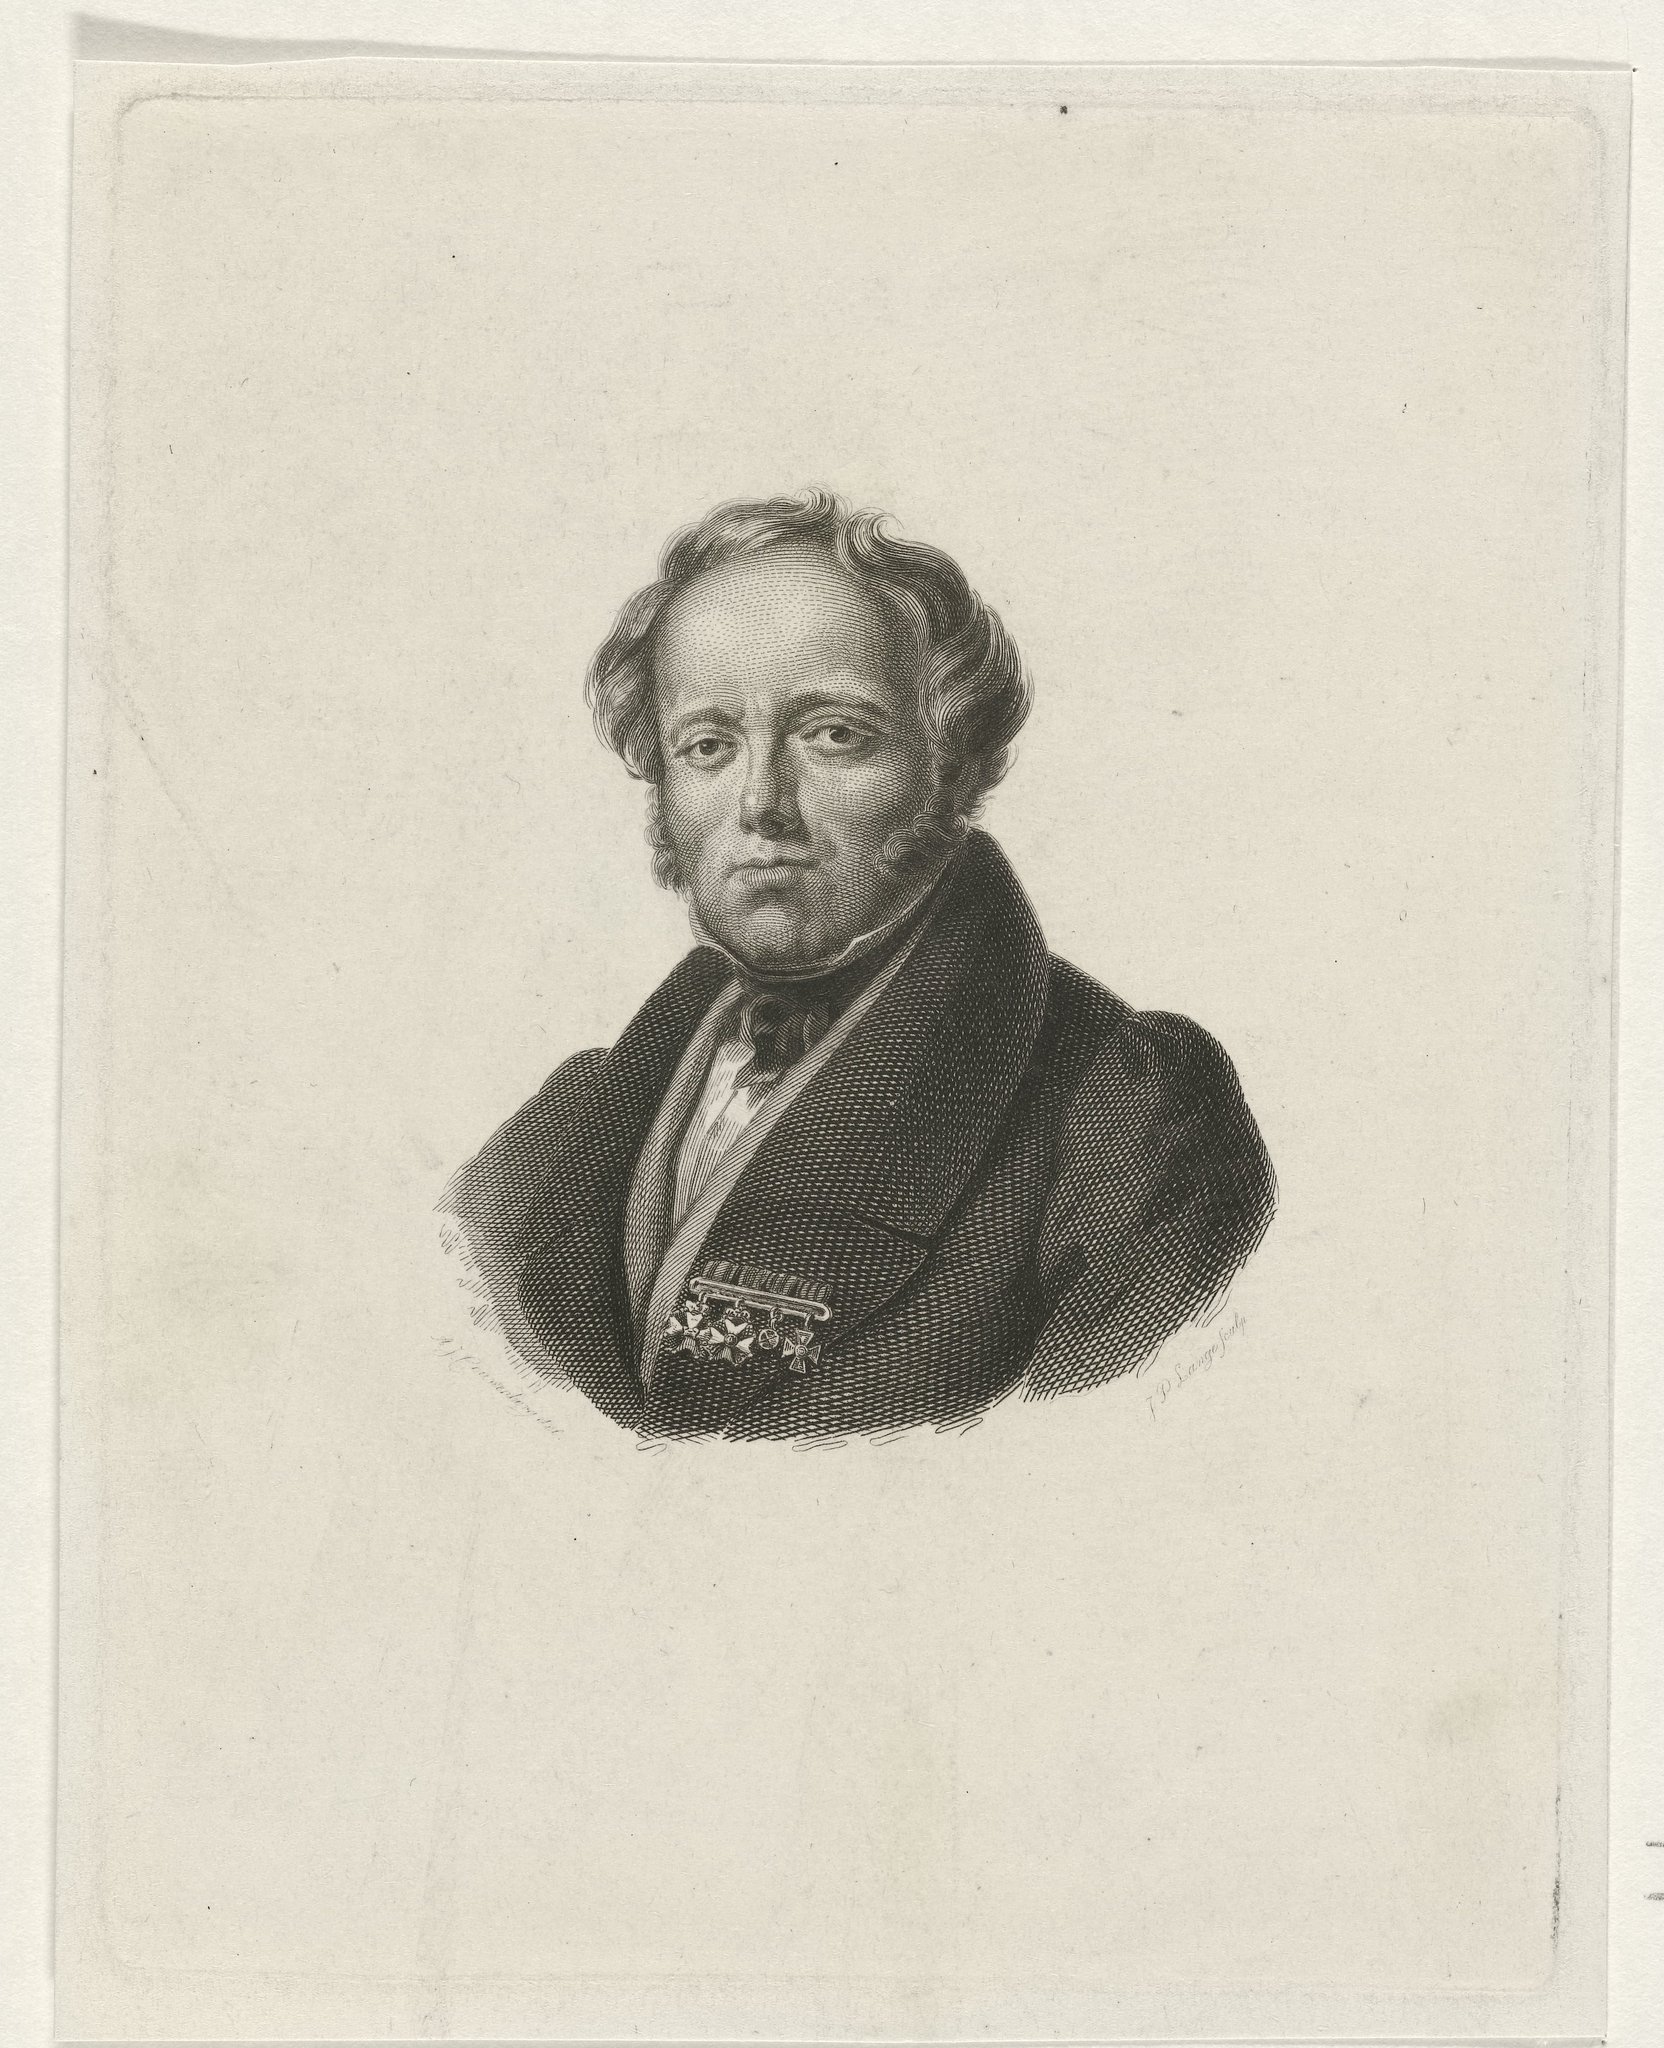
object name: print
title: Portret van Edmond Willem van Dam van Isselt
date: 1820-1849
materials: paper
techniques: engraving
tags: breda, dichter, schrijver, majoor, edmond willem van dam van isselt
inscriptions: collector's mark: Lugt 2228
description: Portretbuste naar links van Edmond Willem van Dam van Isselt, majoor-commandant van de Vrijwillige Jagers.